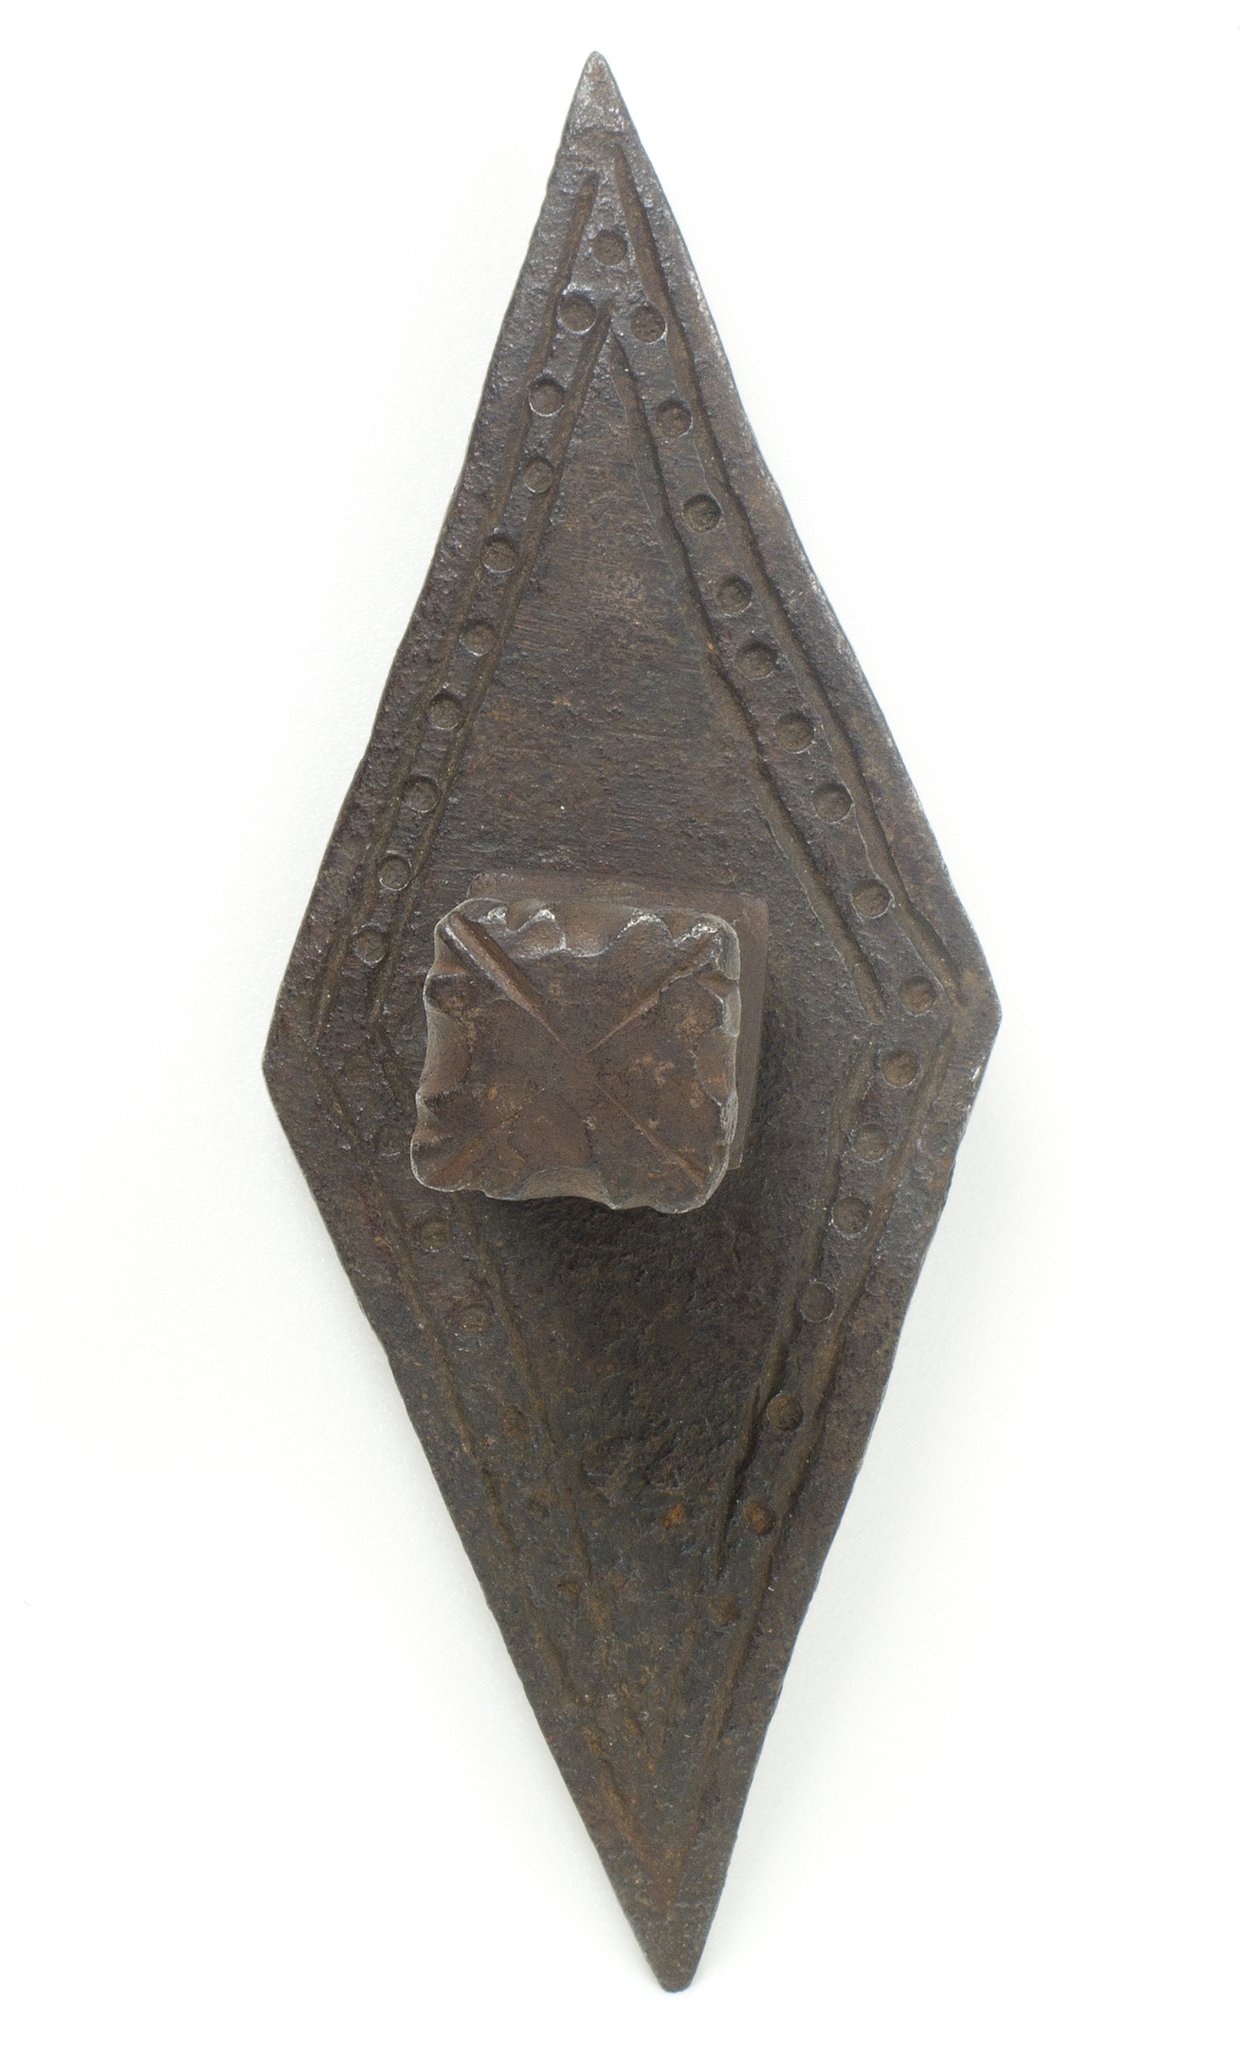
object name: plate and nail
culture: european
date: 1401-1600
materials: iron